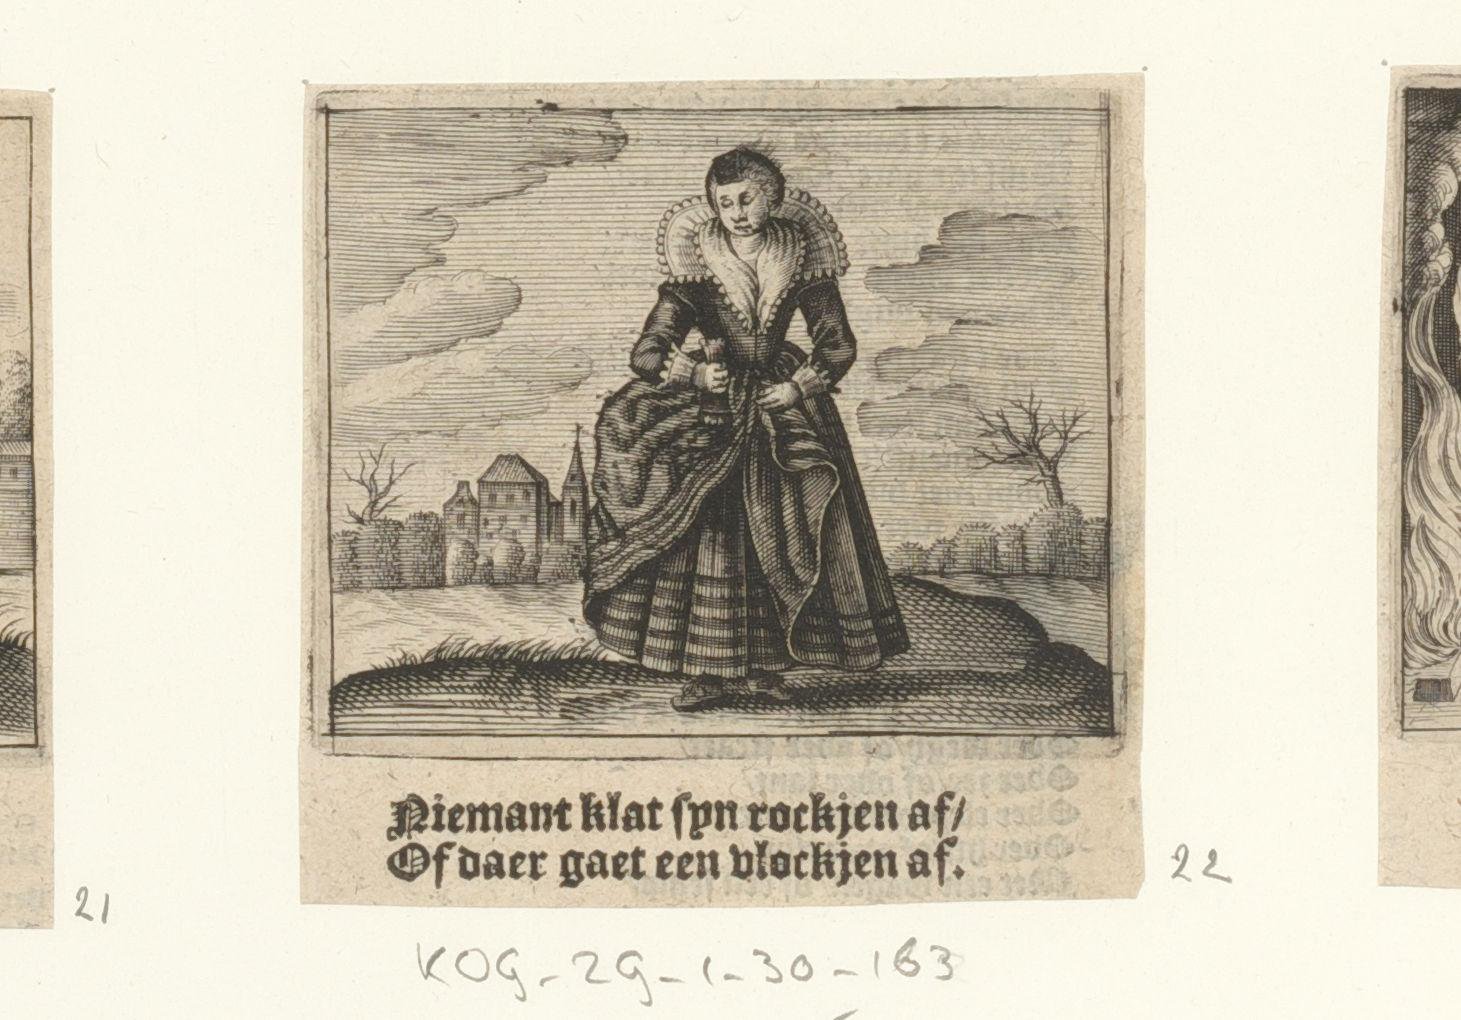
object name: book illustration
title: Vrouw in een open veld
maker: Anonymous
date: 1635-1715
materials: paper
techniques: engraving, letterpress printing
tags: adolescent, young woman, maiden, proverbs, sayings, etc.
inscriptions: collector's mark: Lugt 1641, stamp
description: Veel versies van dit embleem verschenen in verschillende uitgave van Spiegel van den Ouden ende Nieuwen Tydt. Zoals: Cats, Jacob. Spiegel van den Ouden ende Nieuwen-tijt, Bestaende uyt Spreeck-woorden (...). Dordrecht: Jacob Braat, 1647. Maar ook in andere publicaties (1665, 1671, 1715, 1722).